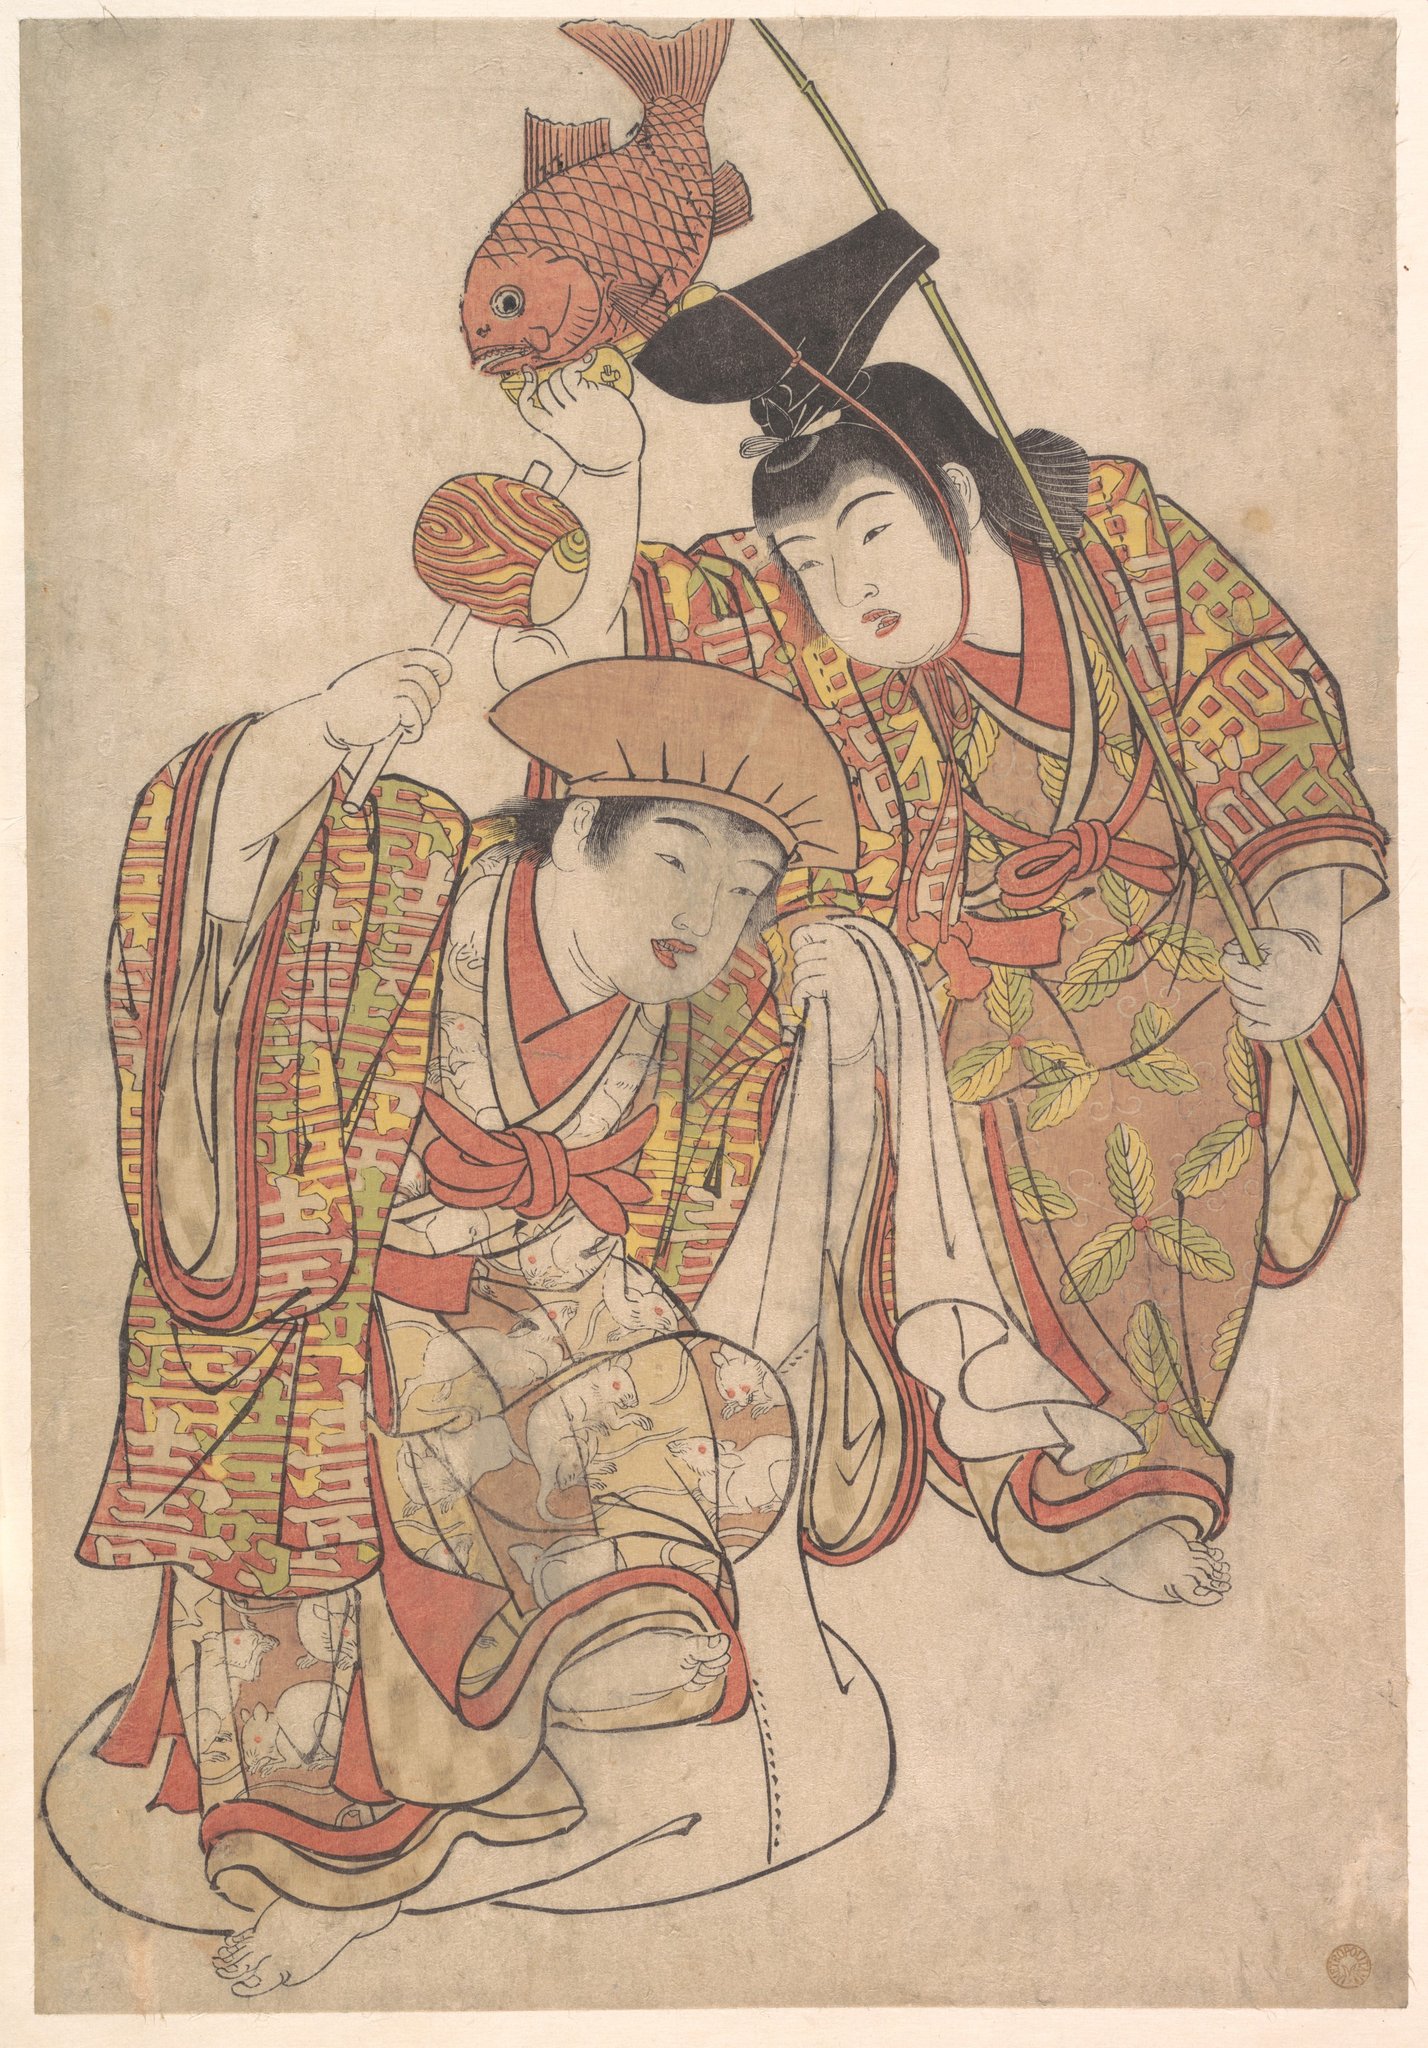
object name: print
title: Boys Maquerading as Daikoku and Ebisu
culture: japanese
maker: kitao shigemasa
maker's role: artist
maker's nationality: japanese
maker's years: 1739-1820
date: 1780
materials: ink, paper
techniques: woodblock print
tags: boys,fish,actors